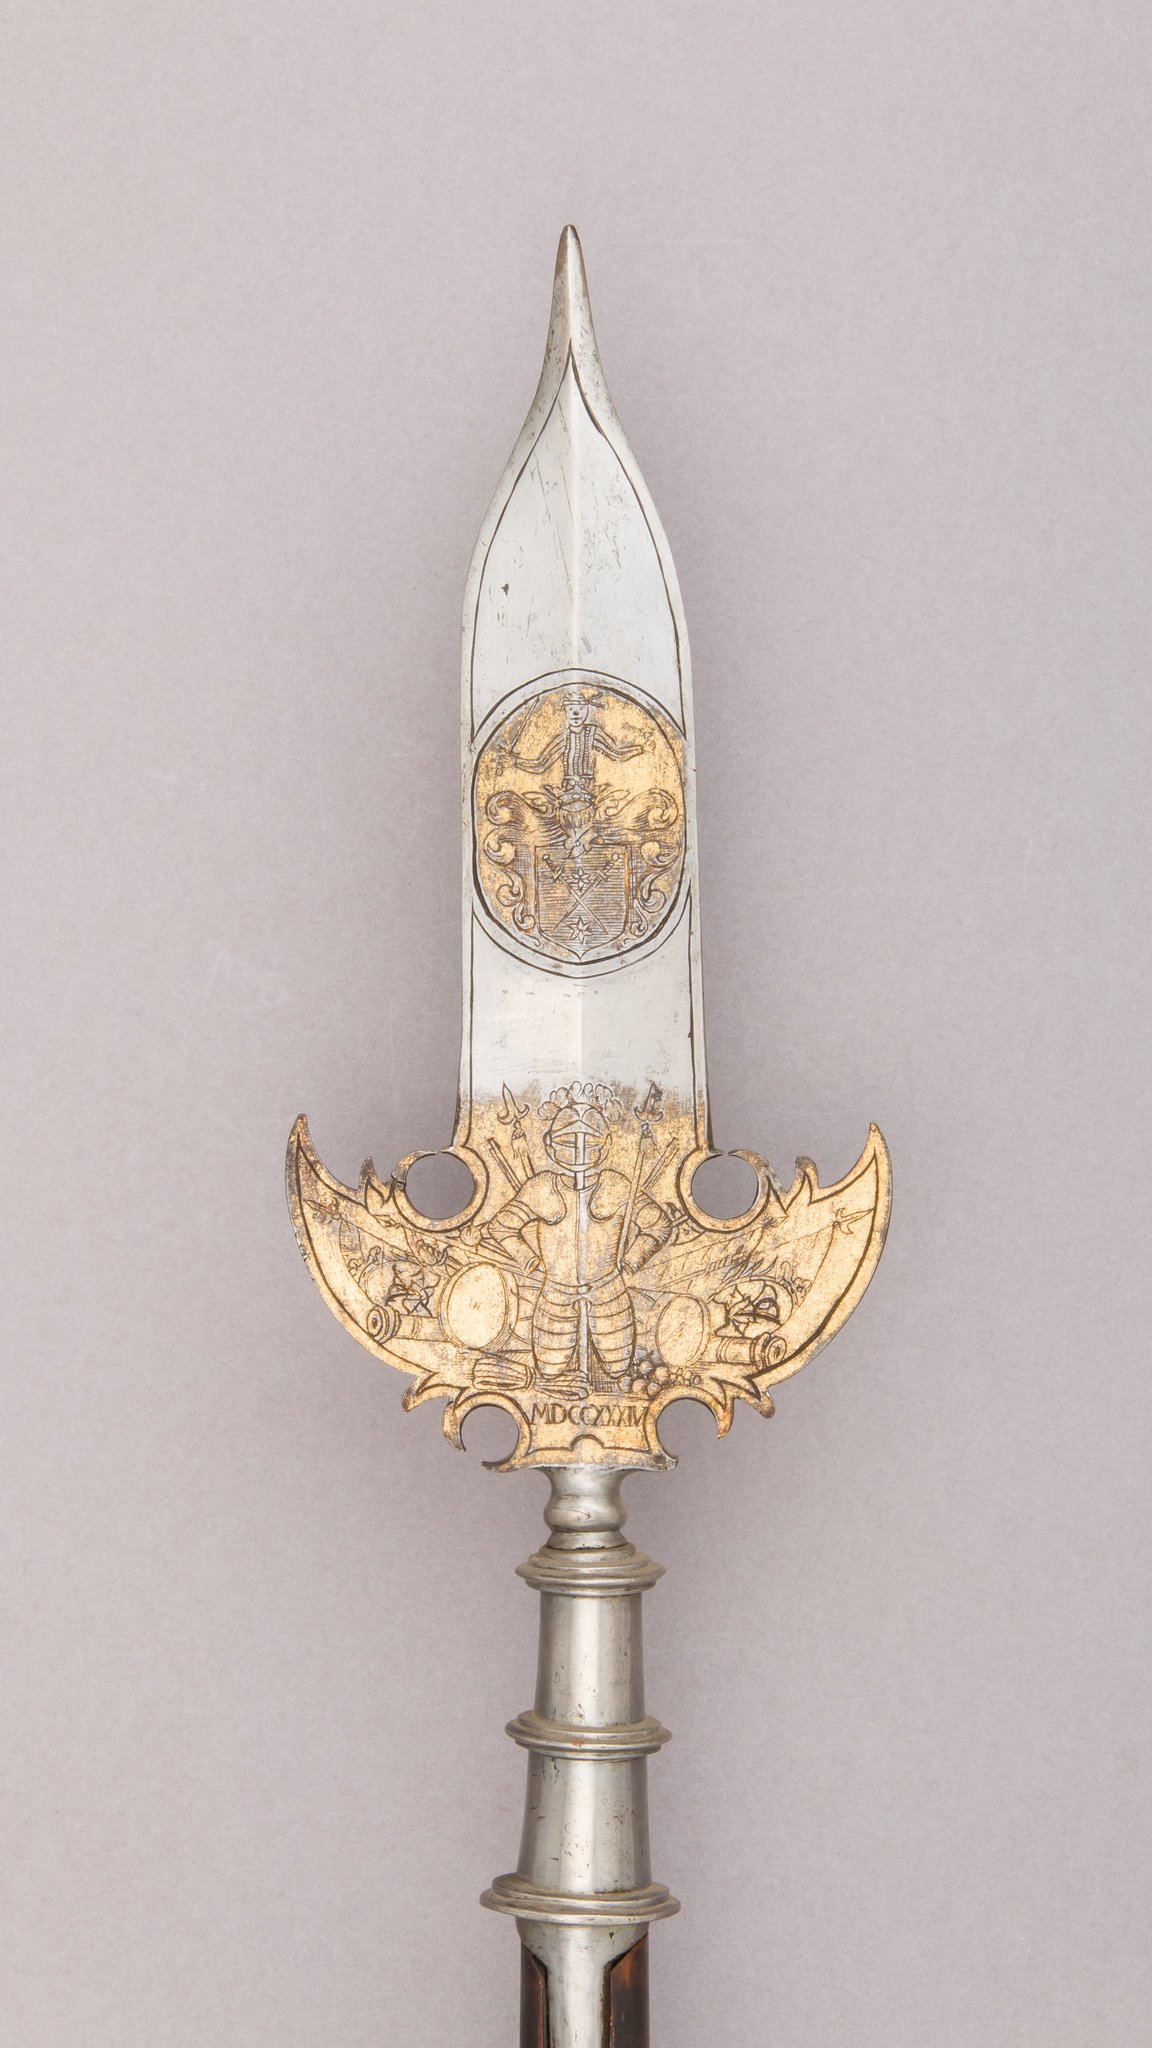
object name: partisan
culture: german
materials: gold, steel, wood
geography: germany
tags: coat of arms